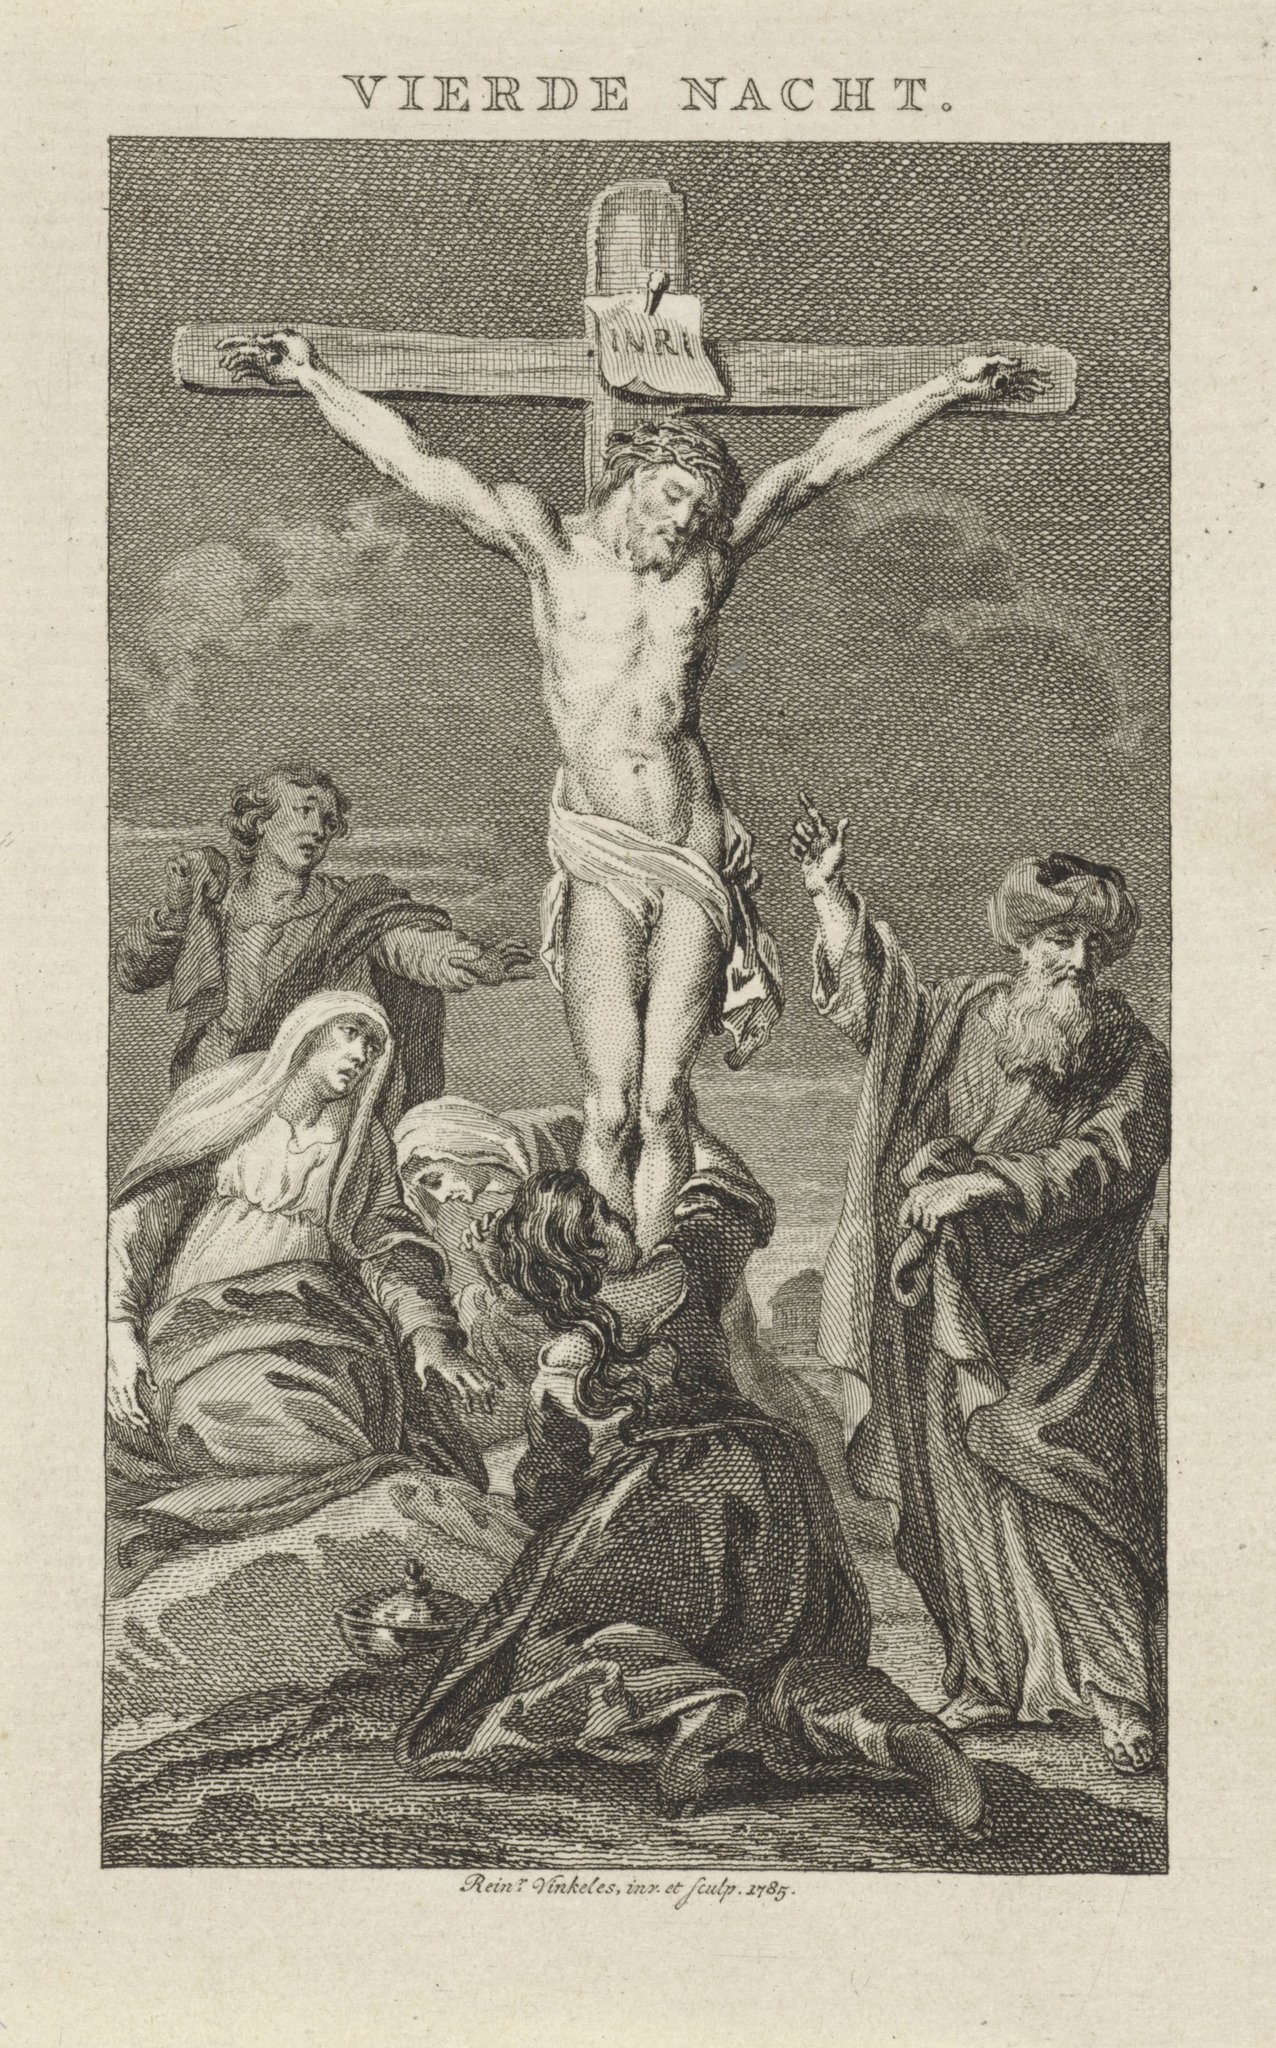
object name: print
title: Christus aan het kruis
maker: reinier vinkeles (i)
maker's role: draughtsman, print maker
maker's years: 1741-1816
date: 1785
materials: paper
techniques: engraving, etching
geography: amsterdam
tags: crucified christ with mary magdalene, who usually weeps and embraces the cross - dd - the three crosses, crucified christ with mary, john, and mary magdalene, night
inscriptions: collector's mark: Lugt 2228